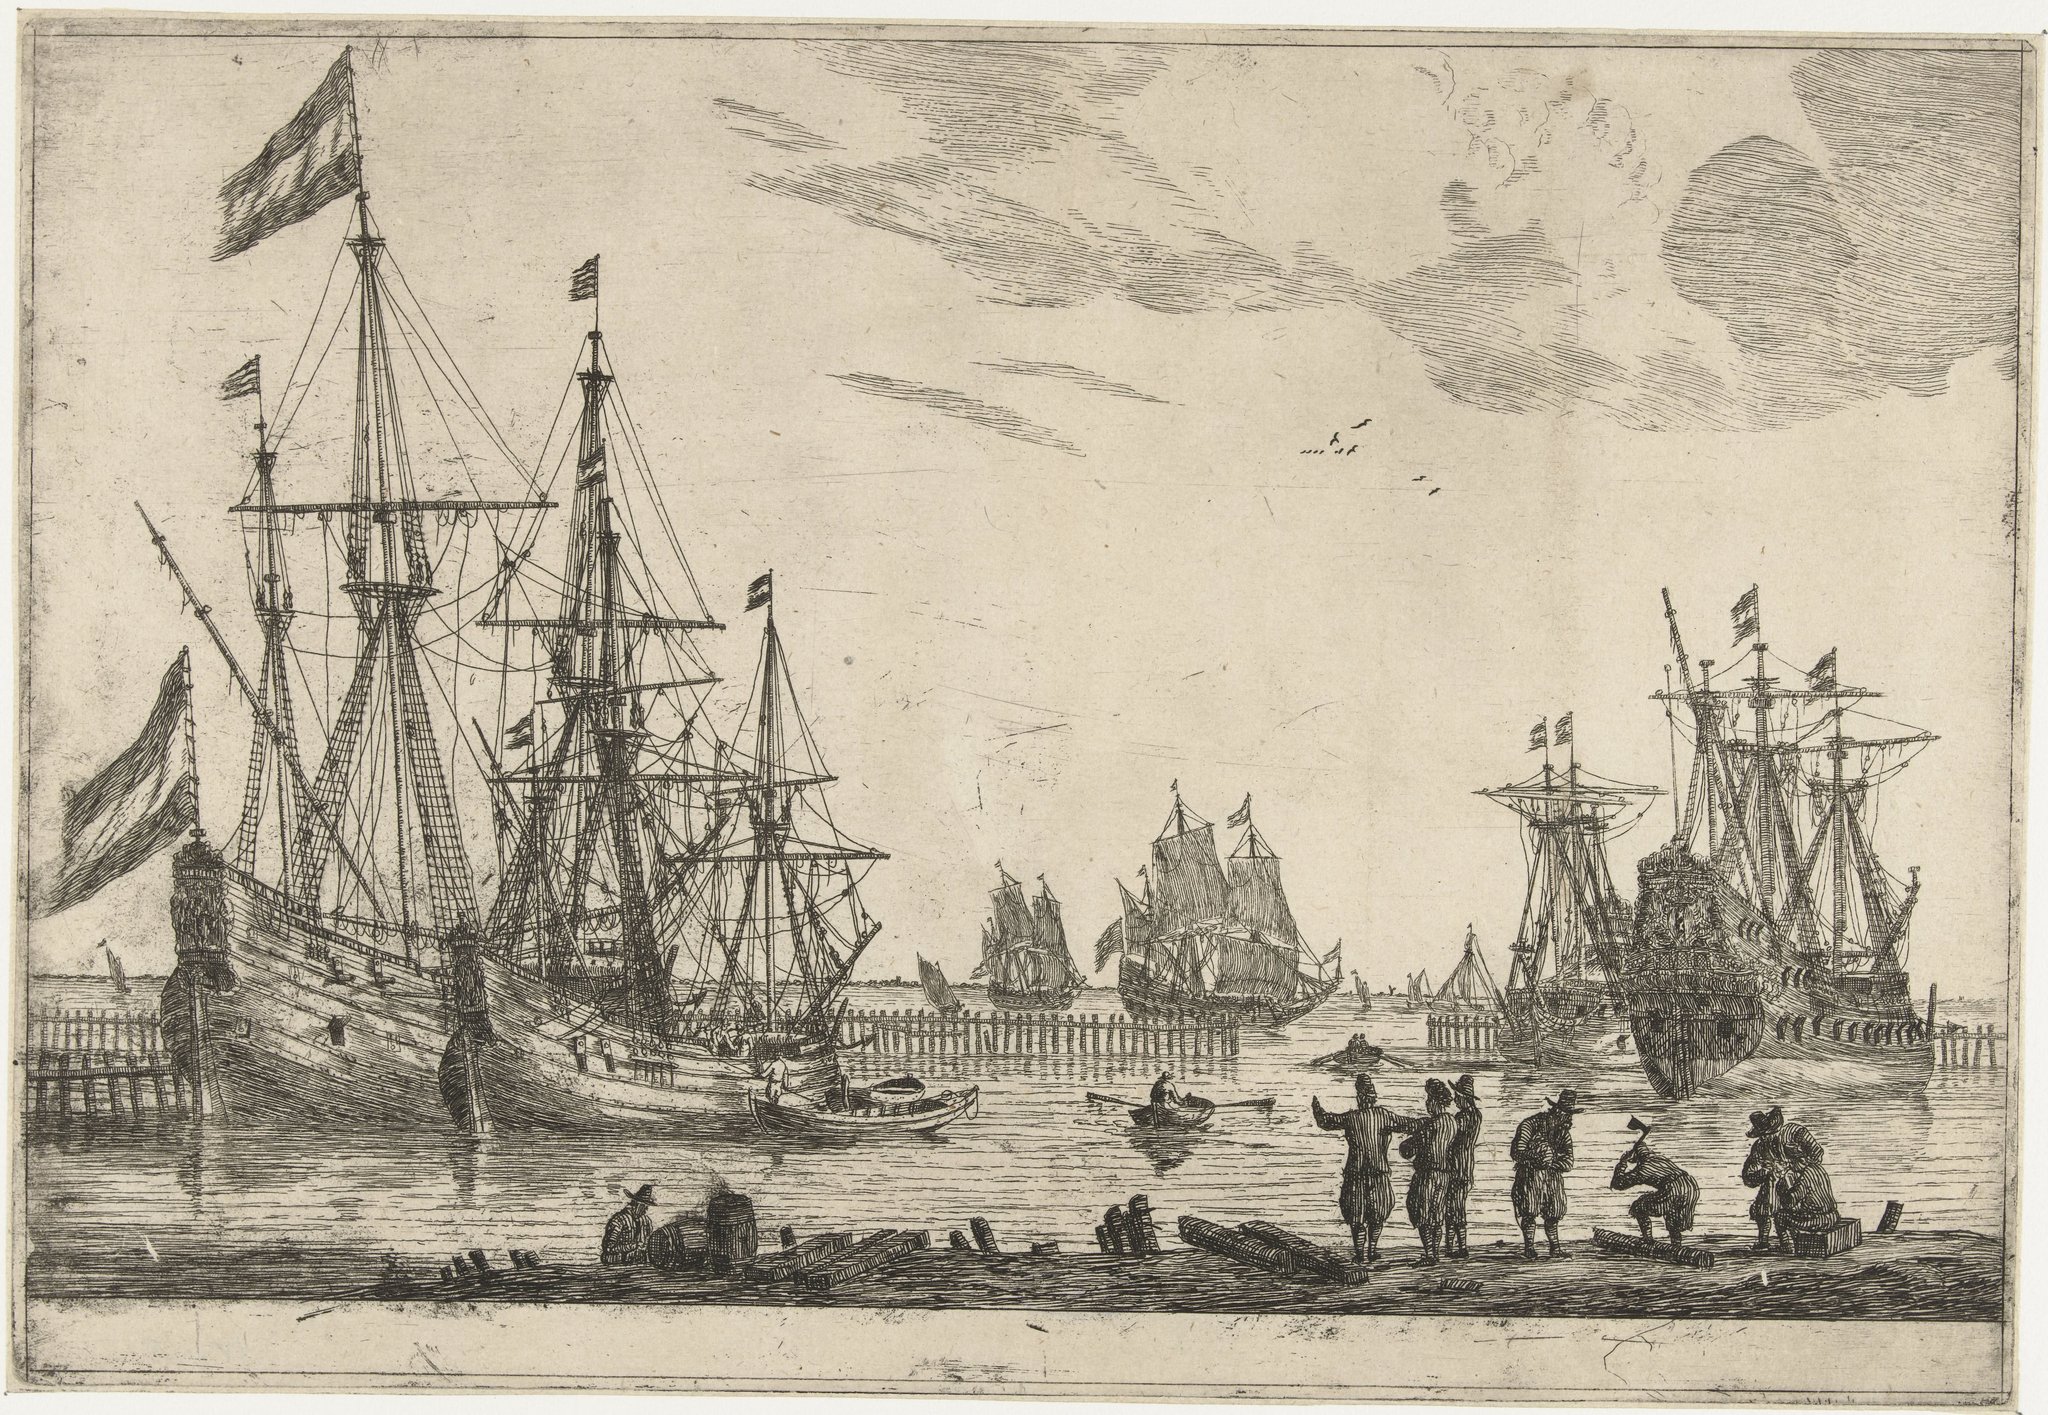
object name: print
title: Vier zeilschepen achter een golfbreker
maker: reinier nooms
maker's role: draughtsman, painter, print maker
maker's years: 1623-1664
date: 1650-1664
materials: paper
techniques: etching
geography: netherlands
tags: sailing-ship, sailing-boat, sailing-ship, sailing-boat (with name), coastal protection work, breakwater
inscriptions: collector's mark: Lugt 2228a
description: Vier Nederlandse zeilschepen, waarvan twee fluitschepen, binnen een omheining vlak bij de wal, deze omheining diende als golfbreker. Daarachter nog enkele varende zeilschepen. Op de wal een aantal mensen.